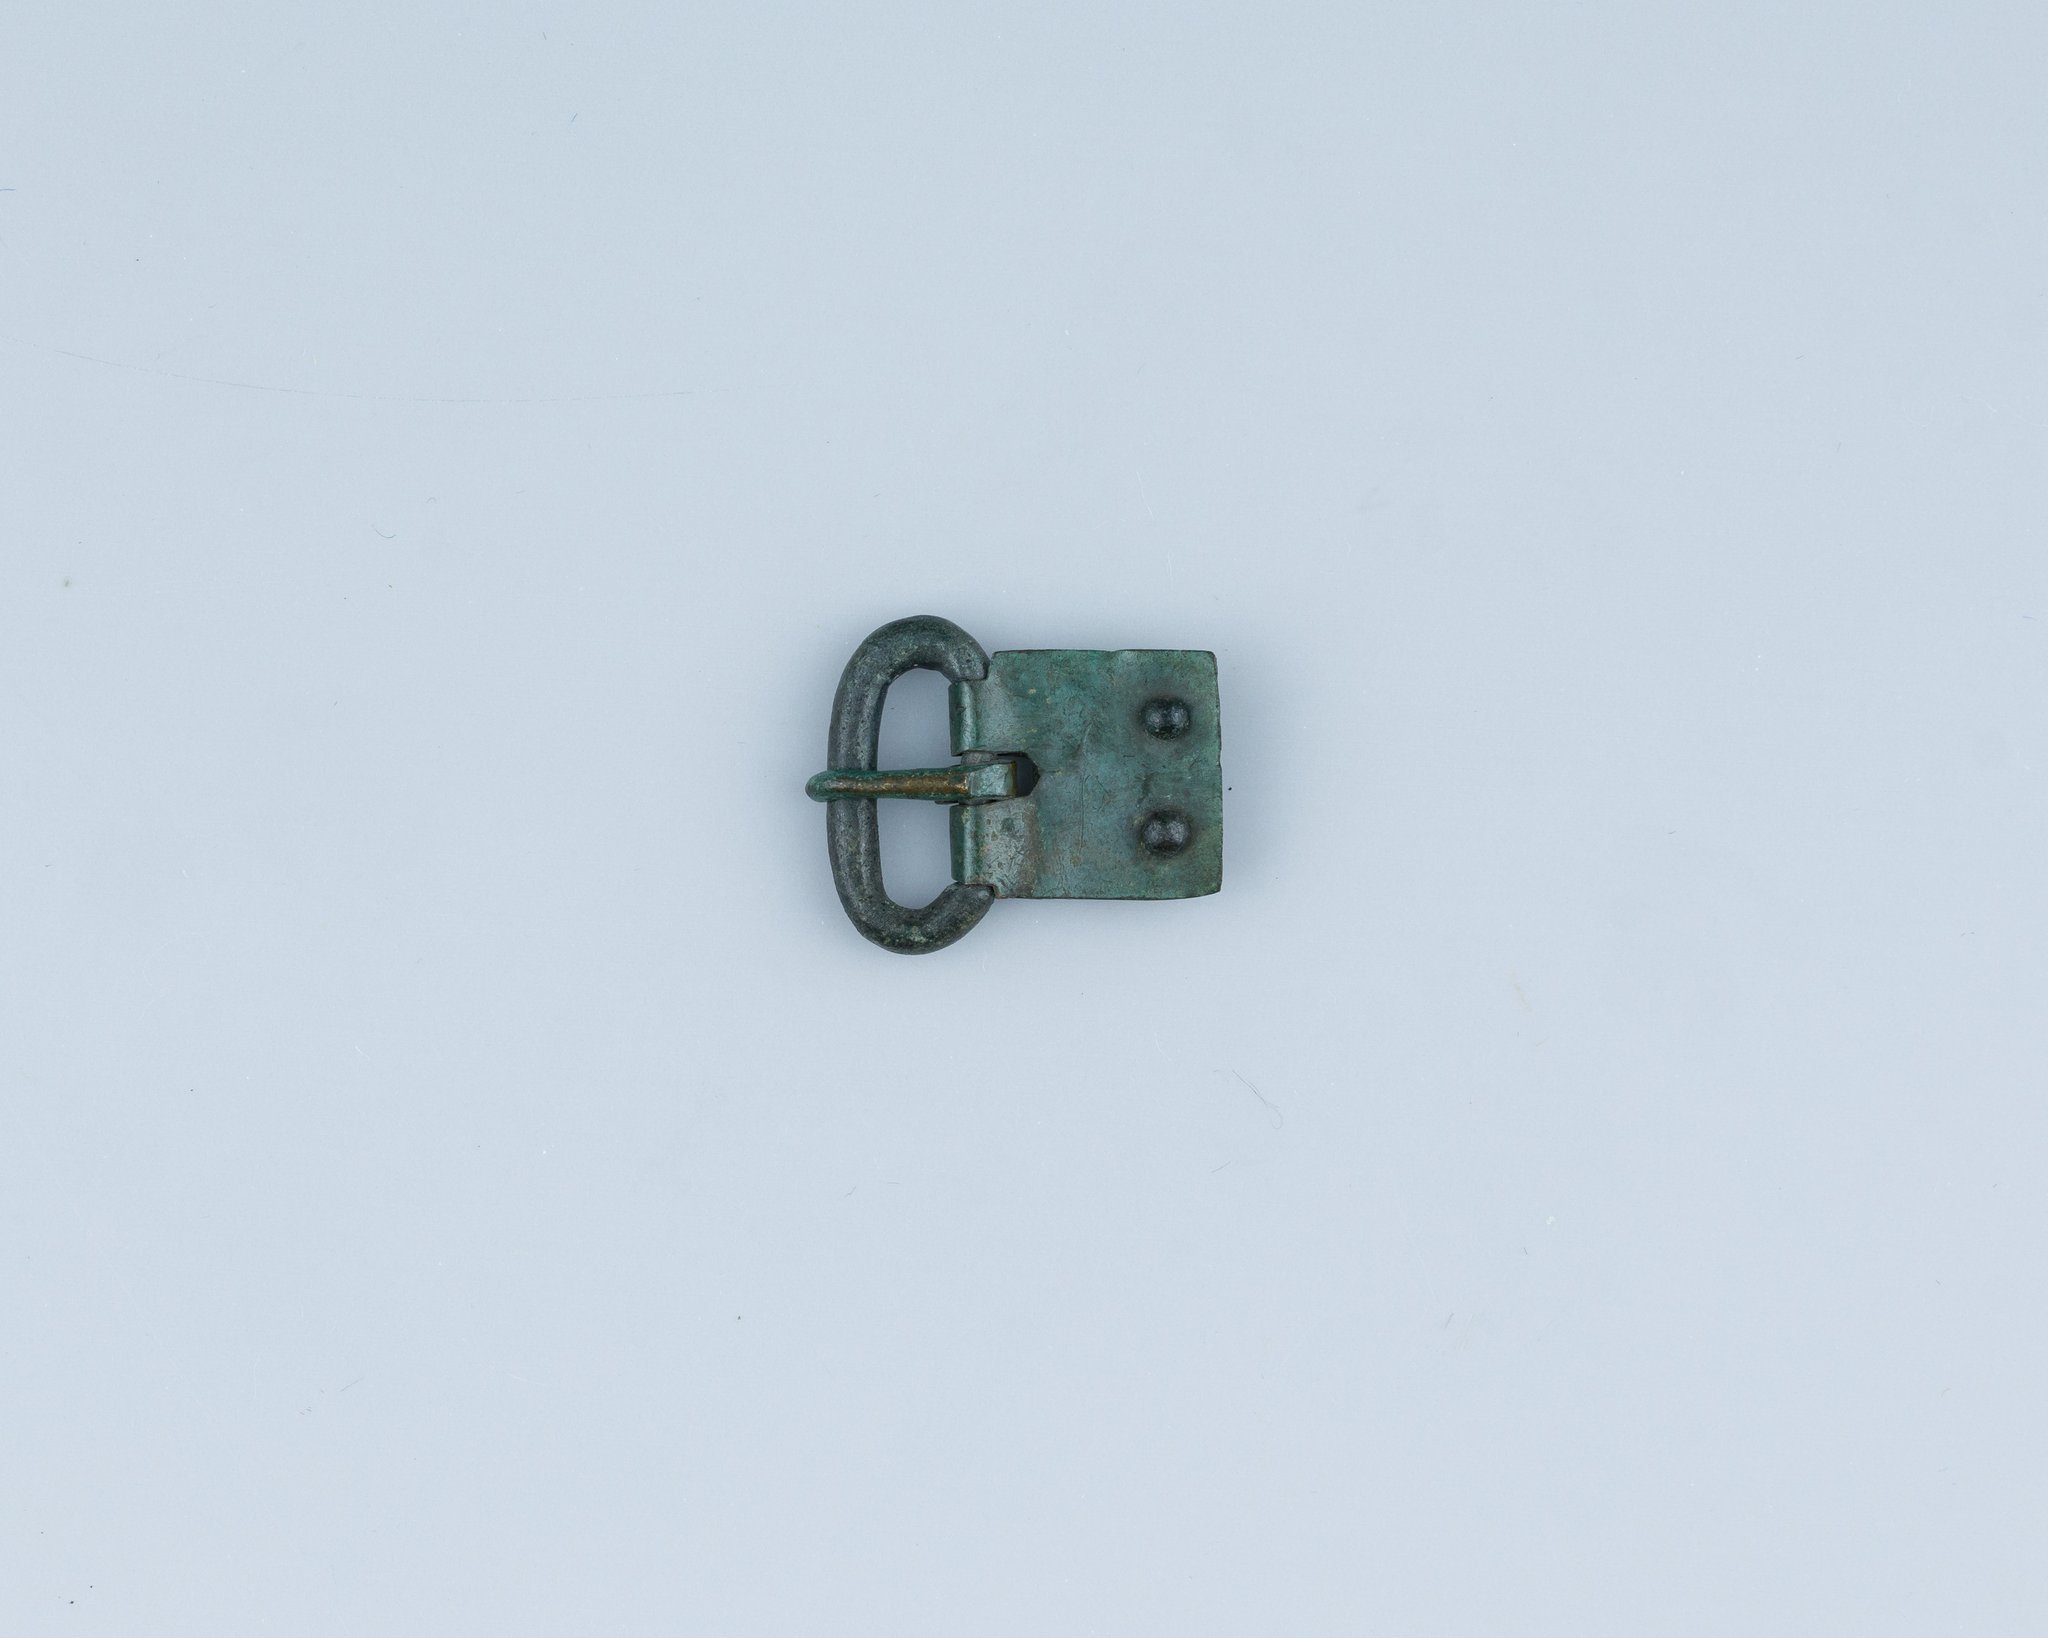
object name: buckle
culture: european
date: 1401-1600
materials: bronze